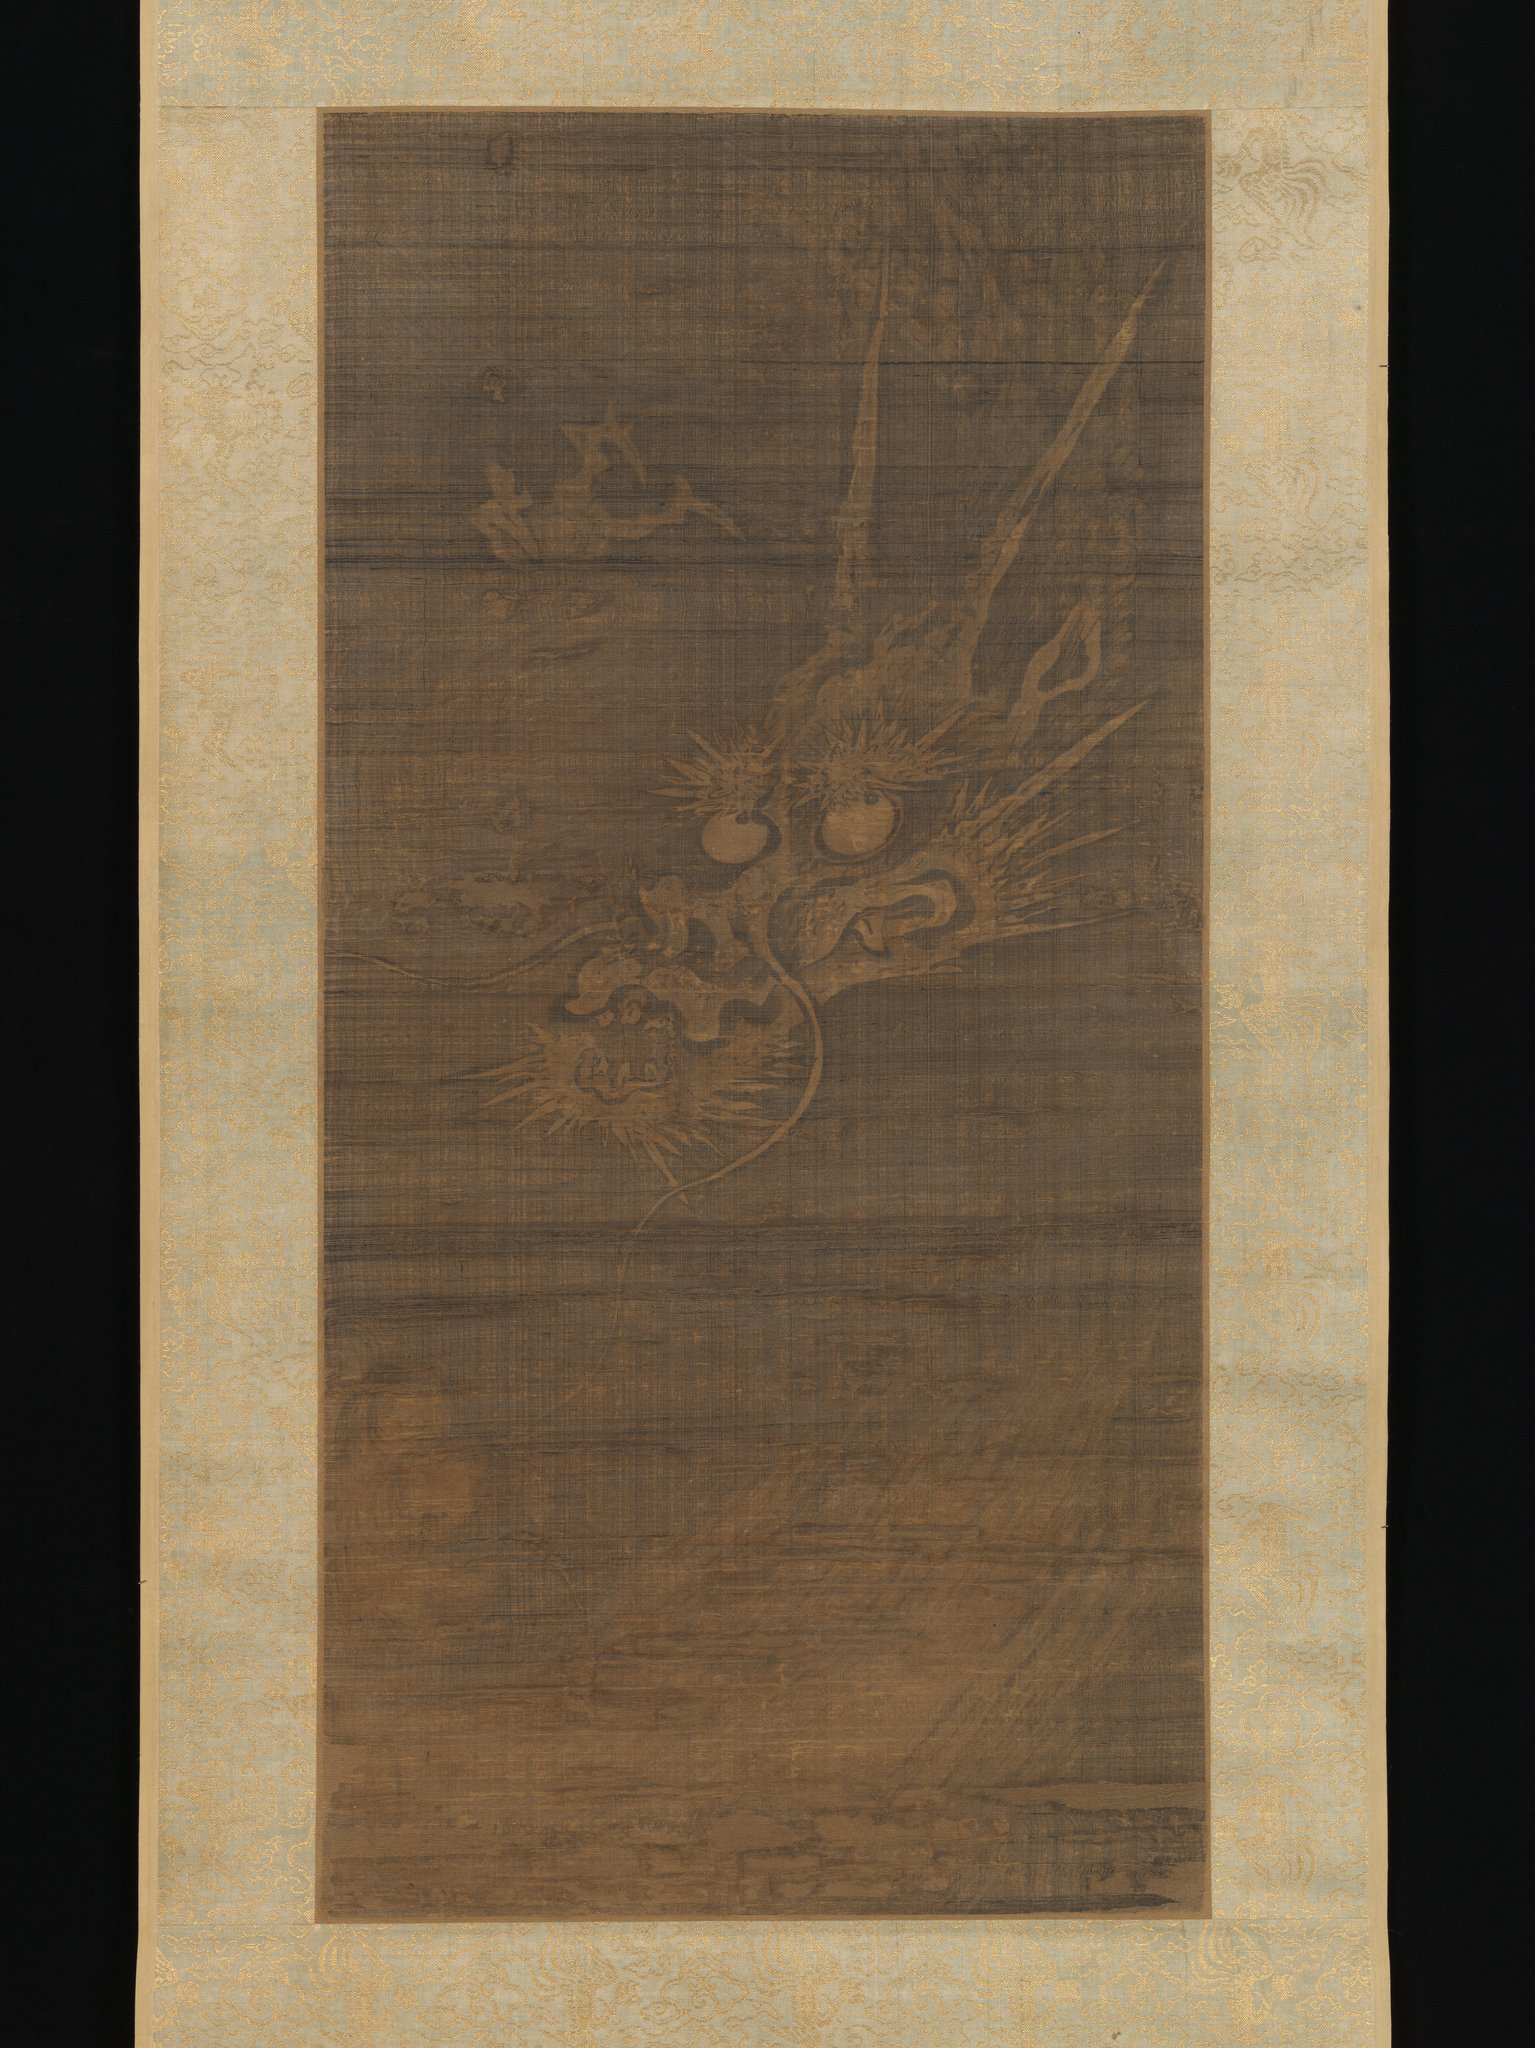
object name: hanging scroll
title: Dragon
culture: chinese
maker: unidentified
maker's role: artist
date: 1301-1400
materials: ink, silk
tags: dragons